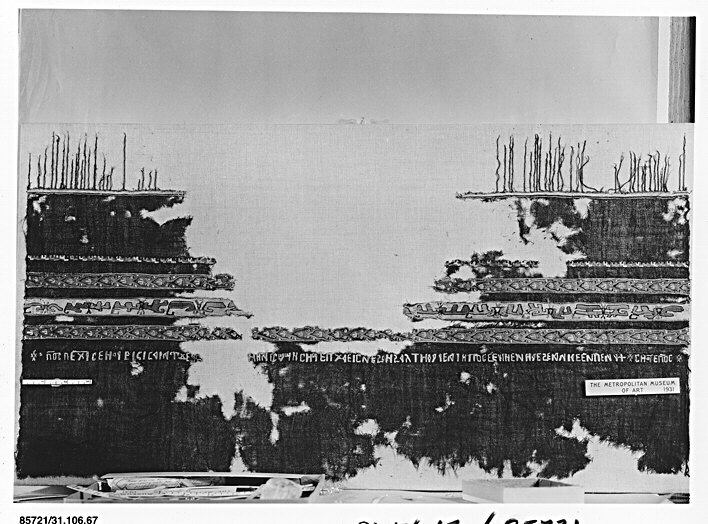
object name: textile fragment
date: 701-900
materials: linen, wool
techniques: weave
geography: egypt